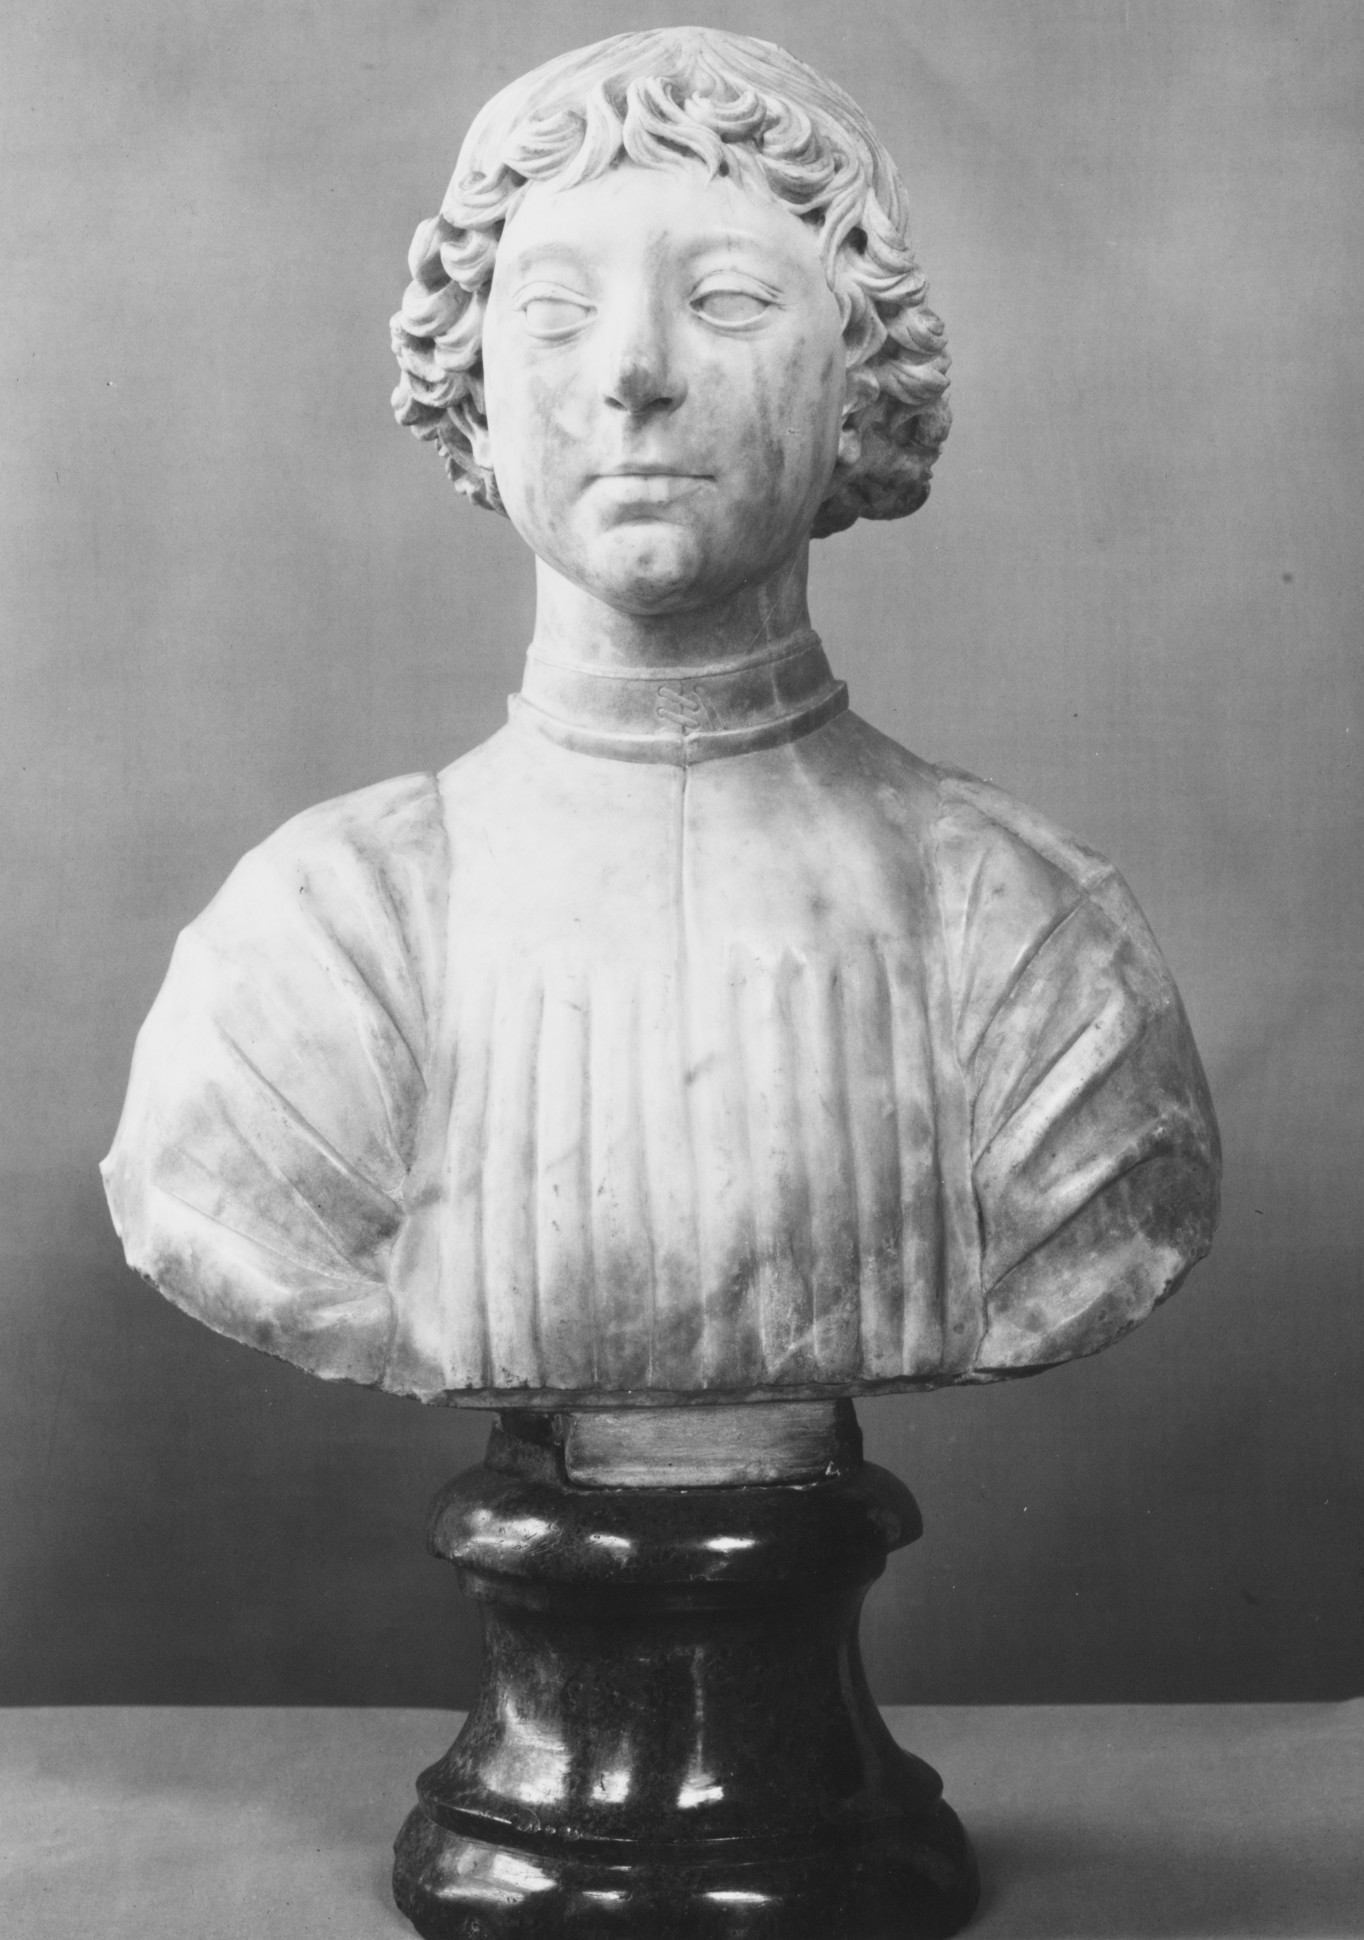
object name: bust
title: Portrait of a Youth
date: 1467-1500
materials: marble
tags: men,portraits